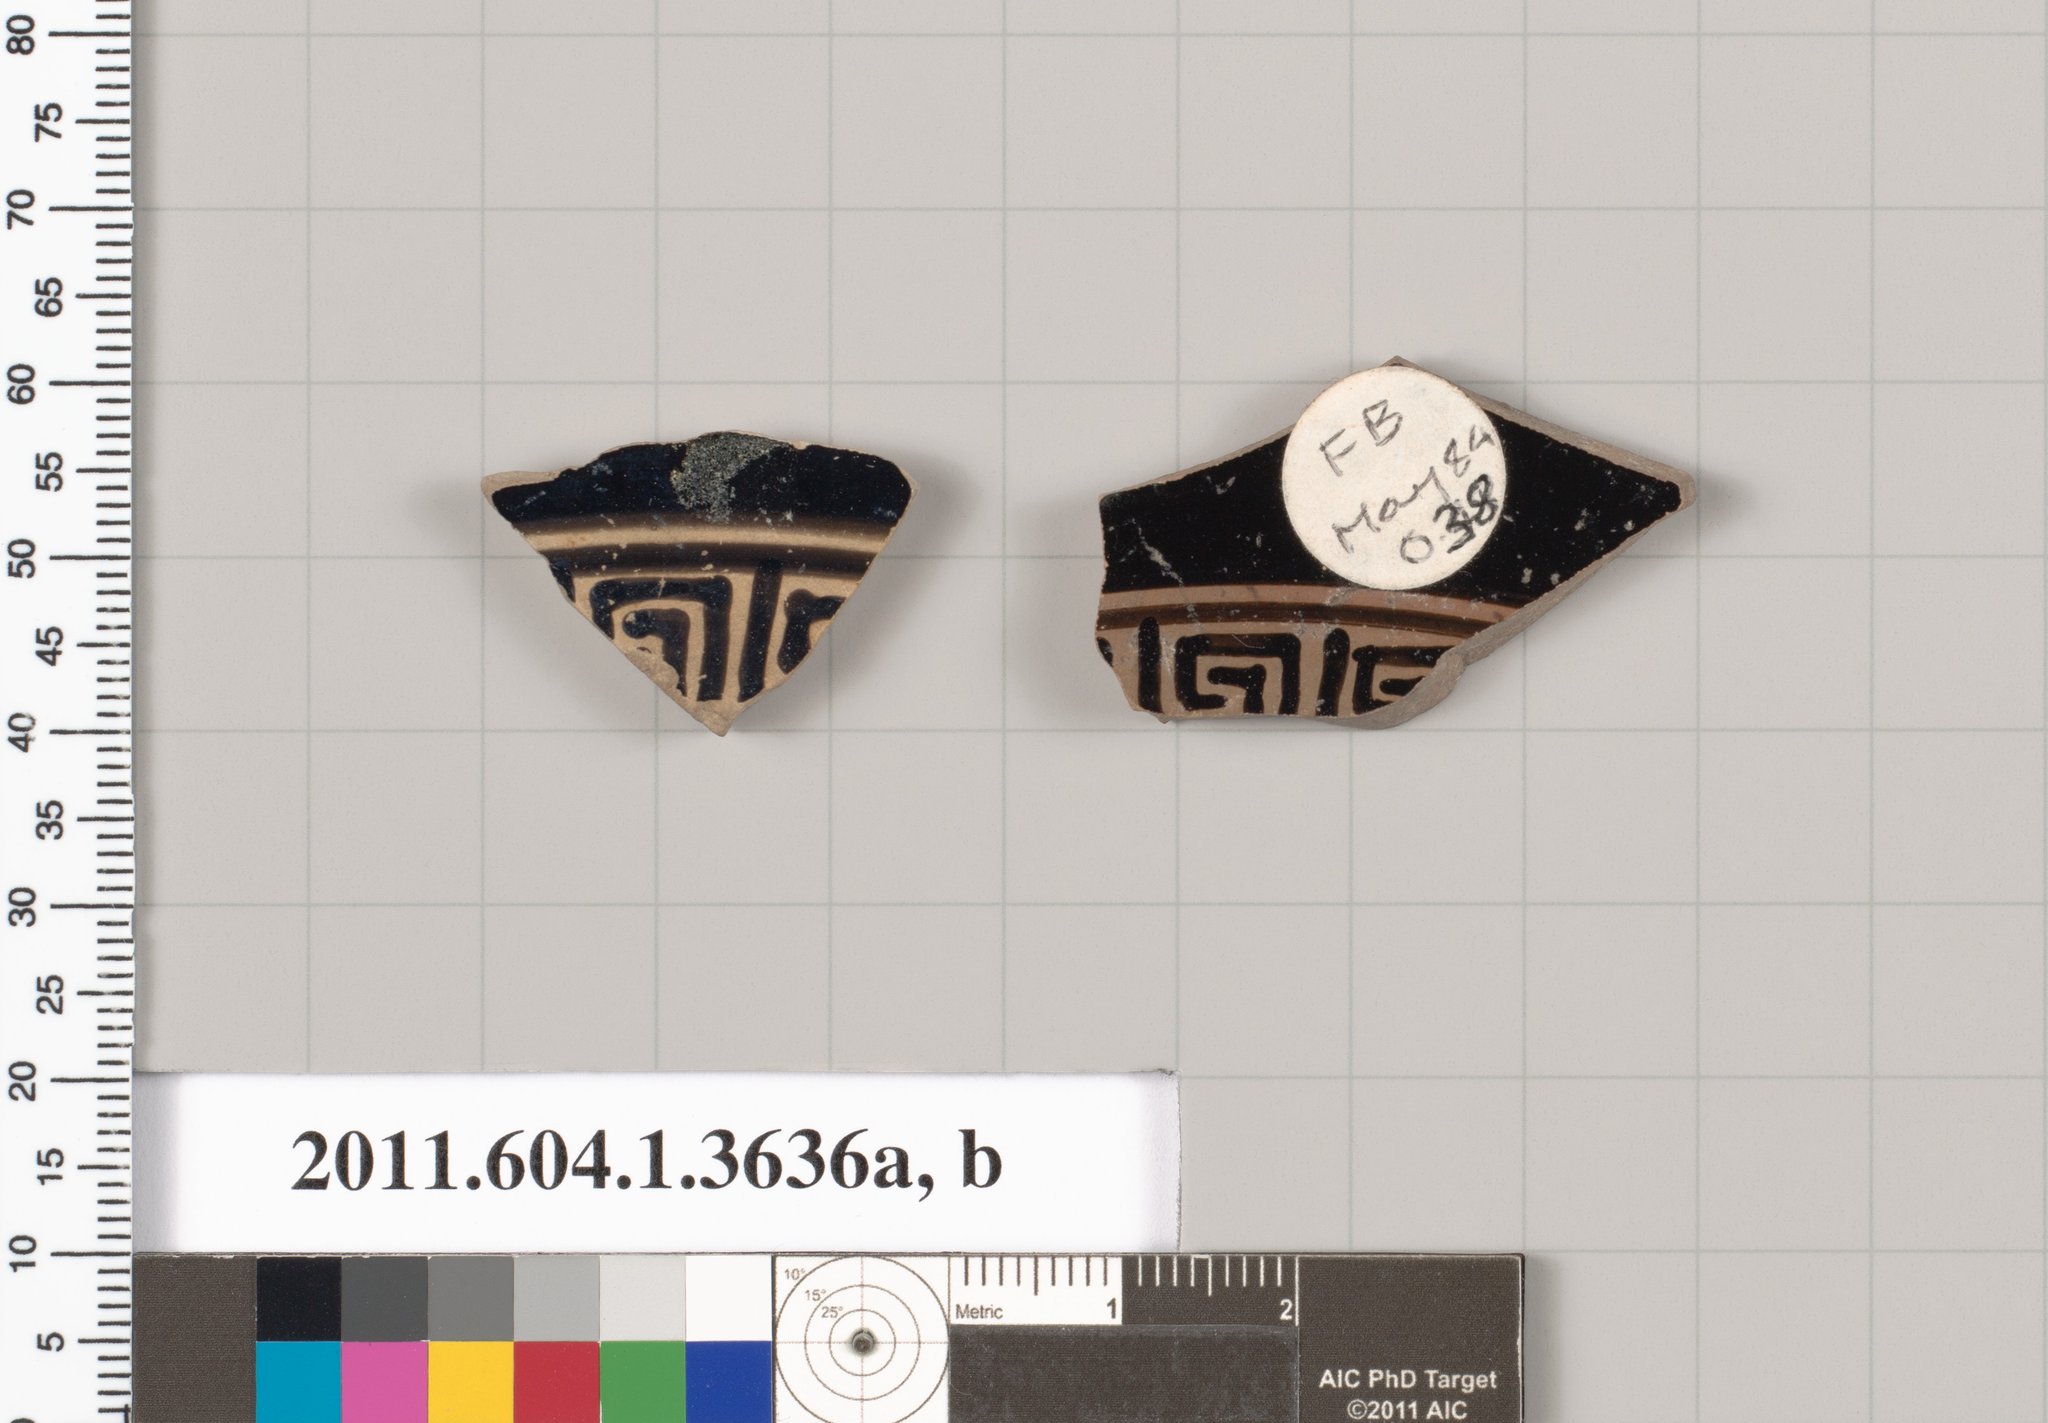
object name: kylix fragment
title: Terracotta fragments of kylikes (drinking cups)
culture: greek, attic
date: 500-470 BCE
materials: terracotta